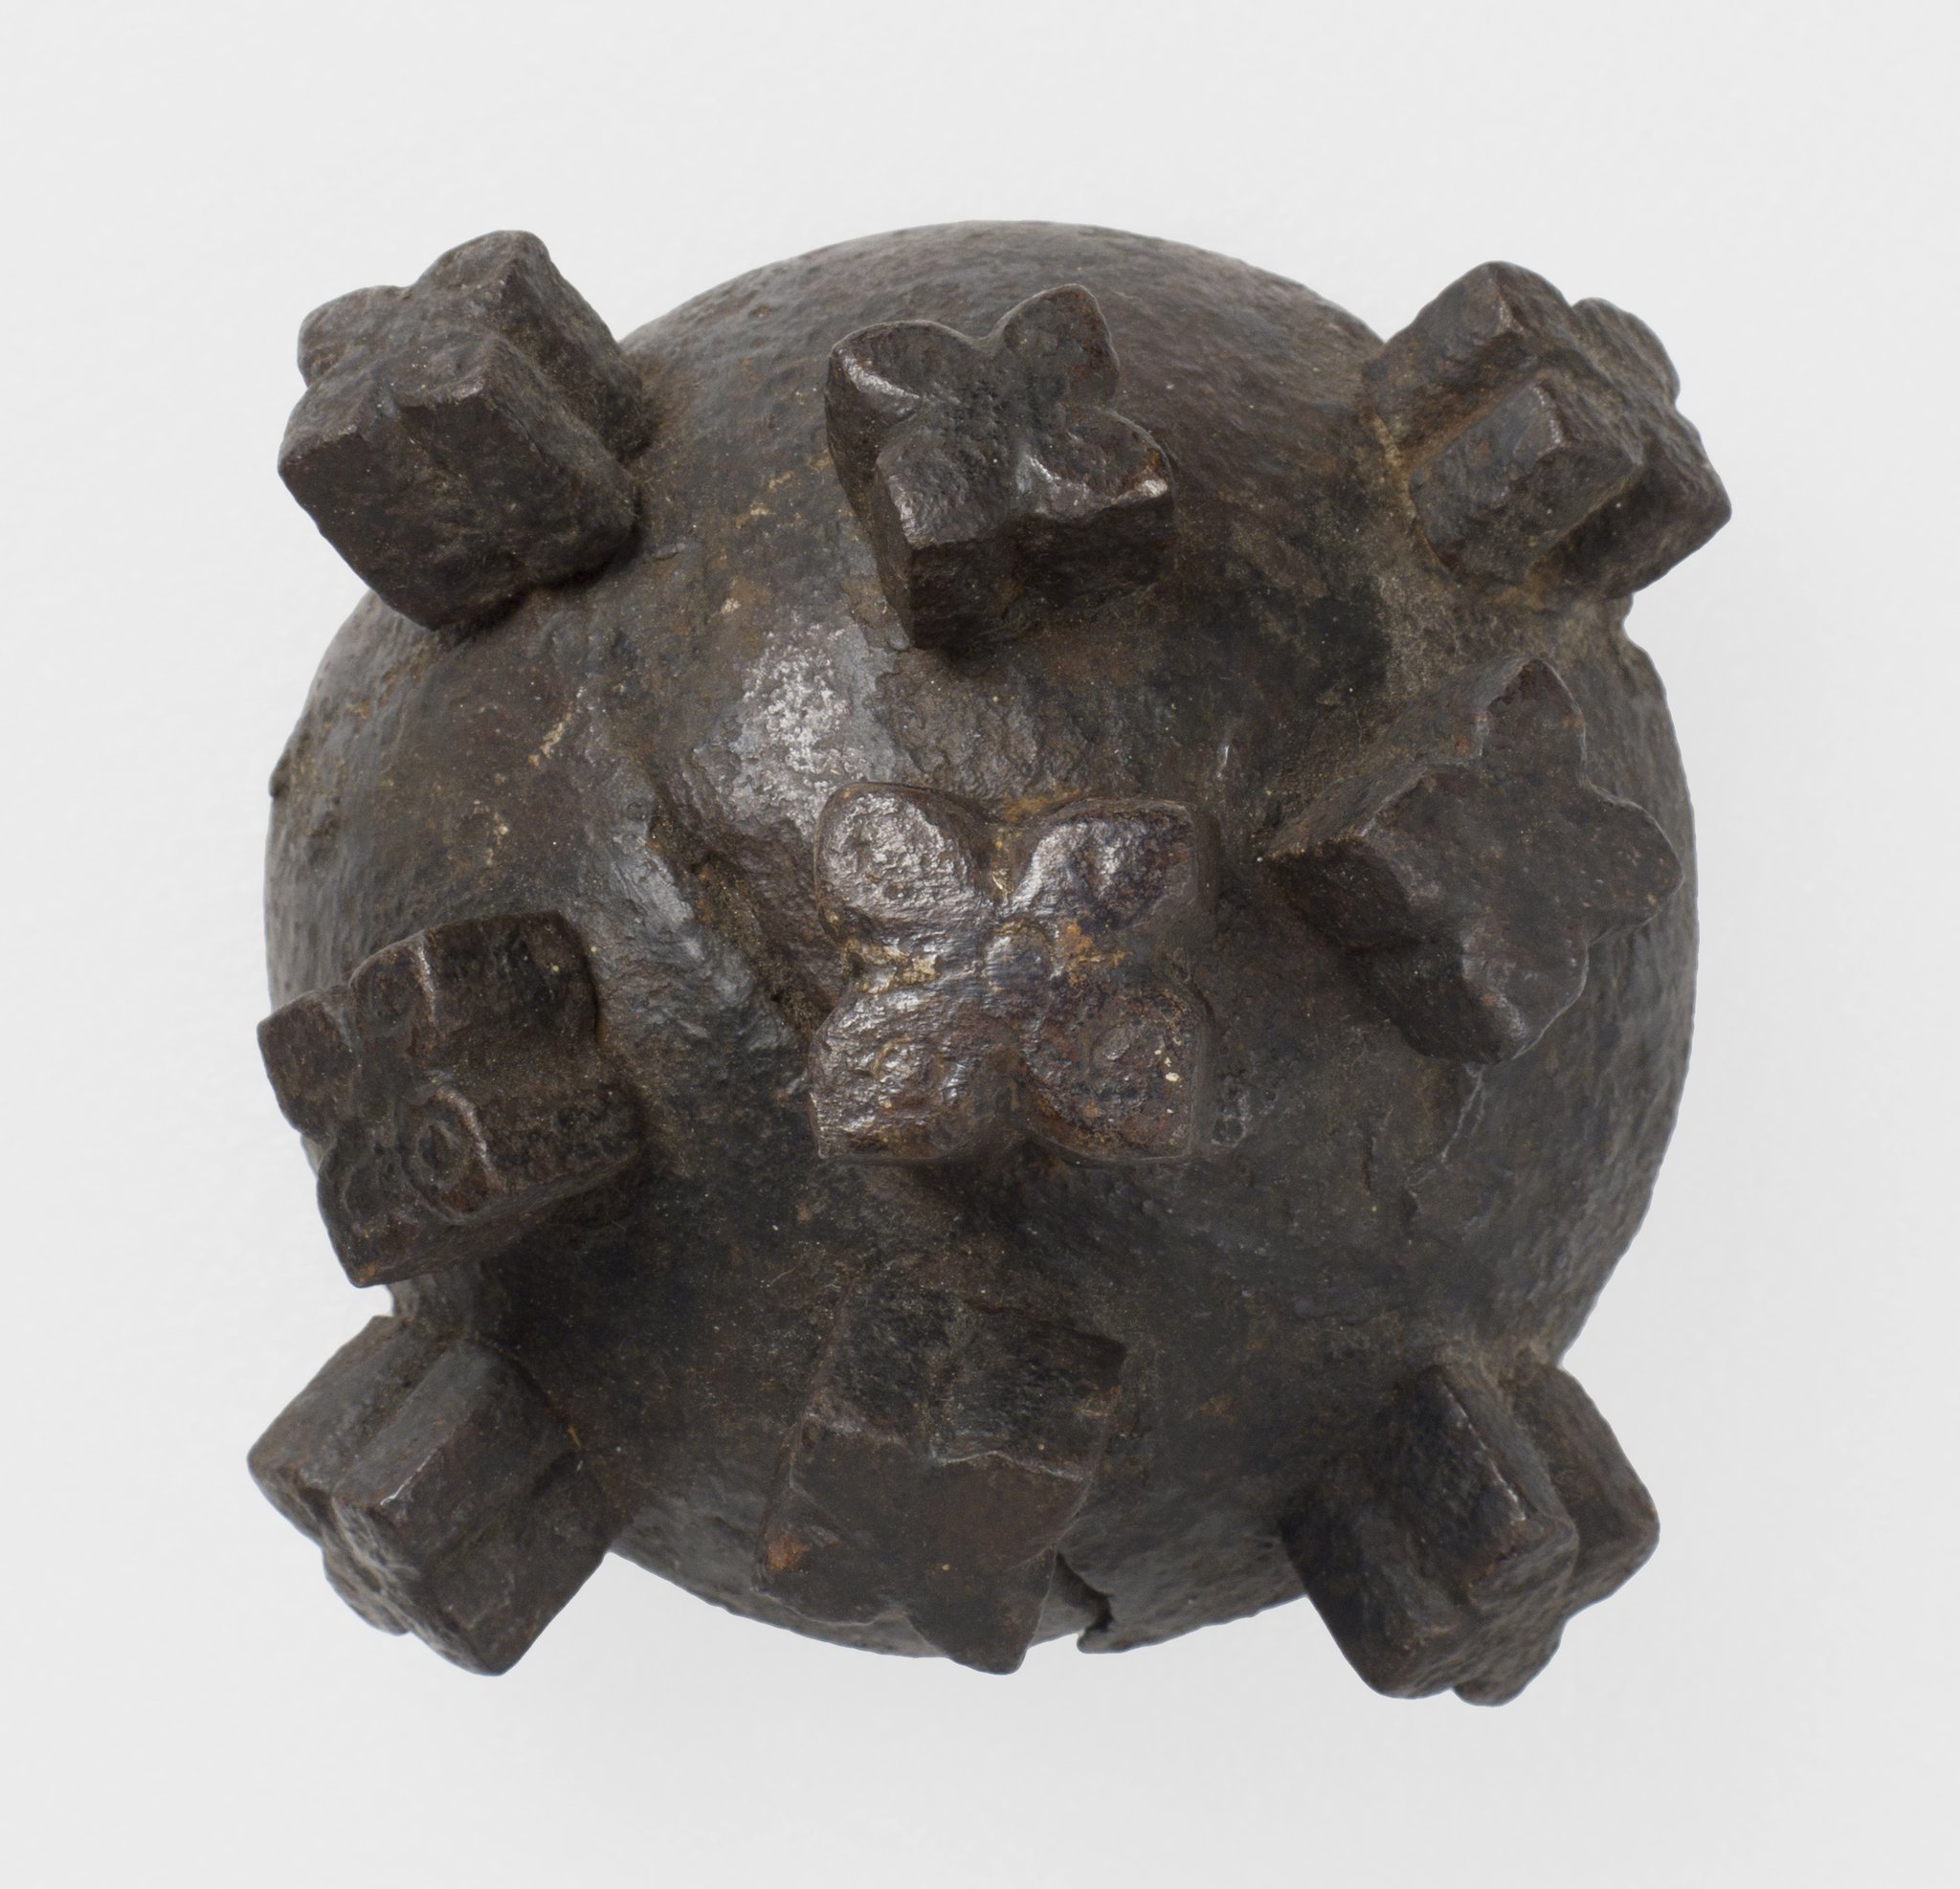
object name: bos and nail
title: Boss and Nail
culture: european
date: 1401-1600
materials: iron